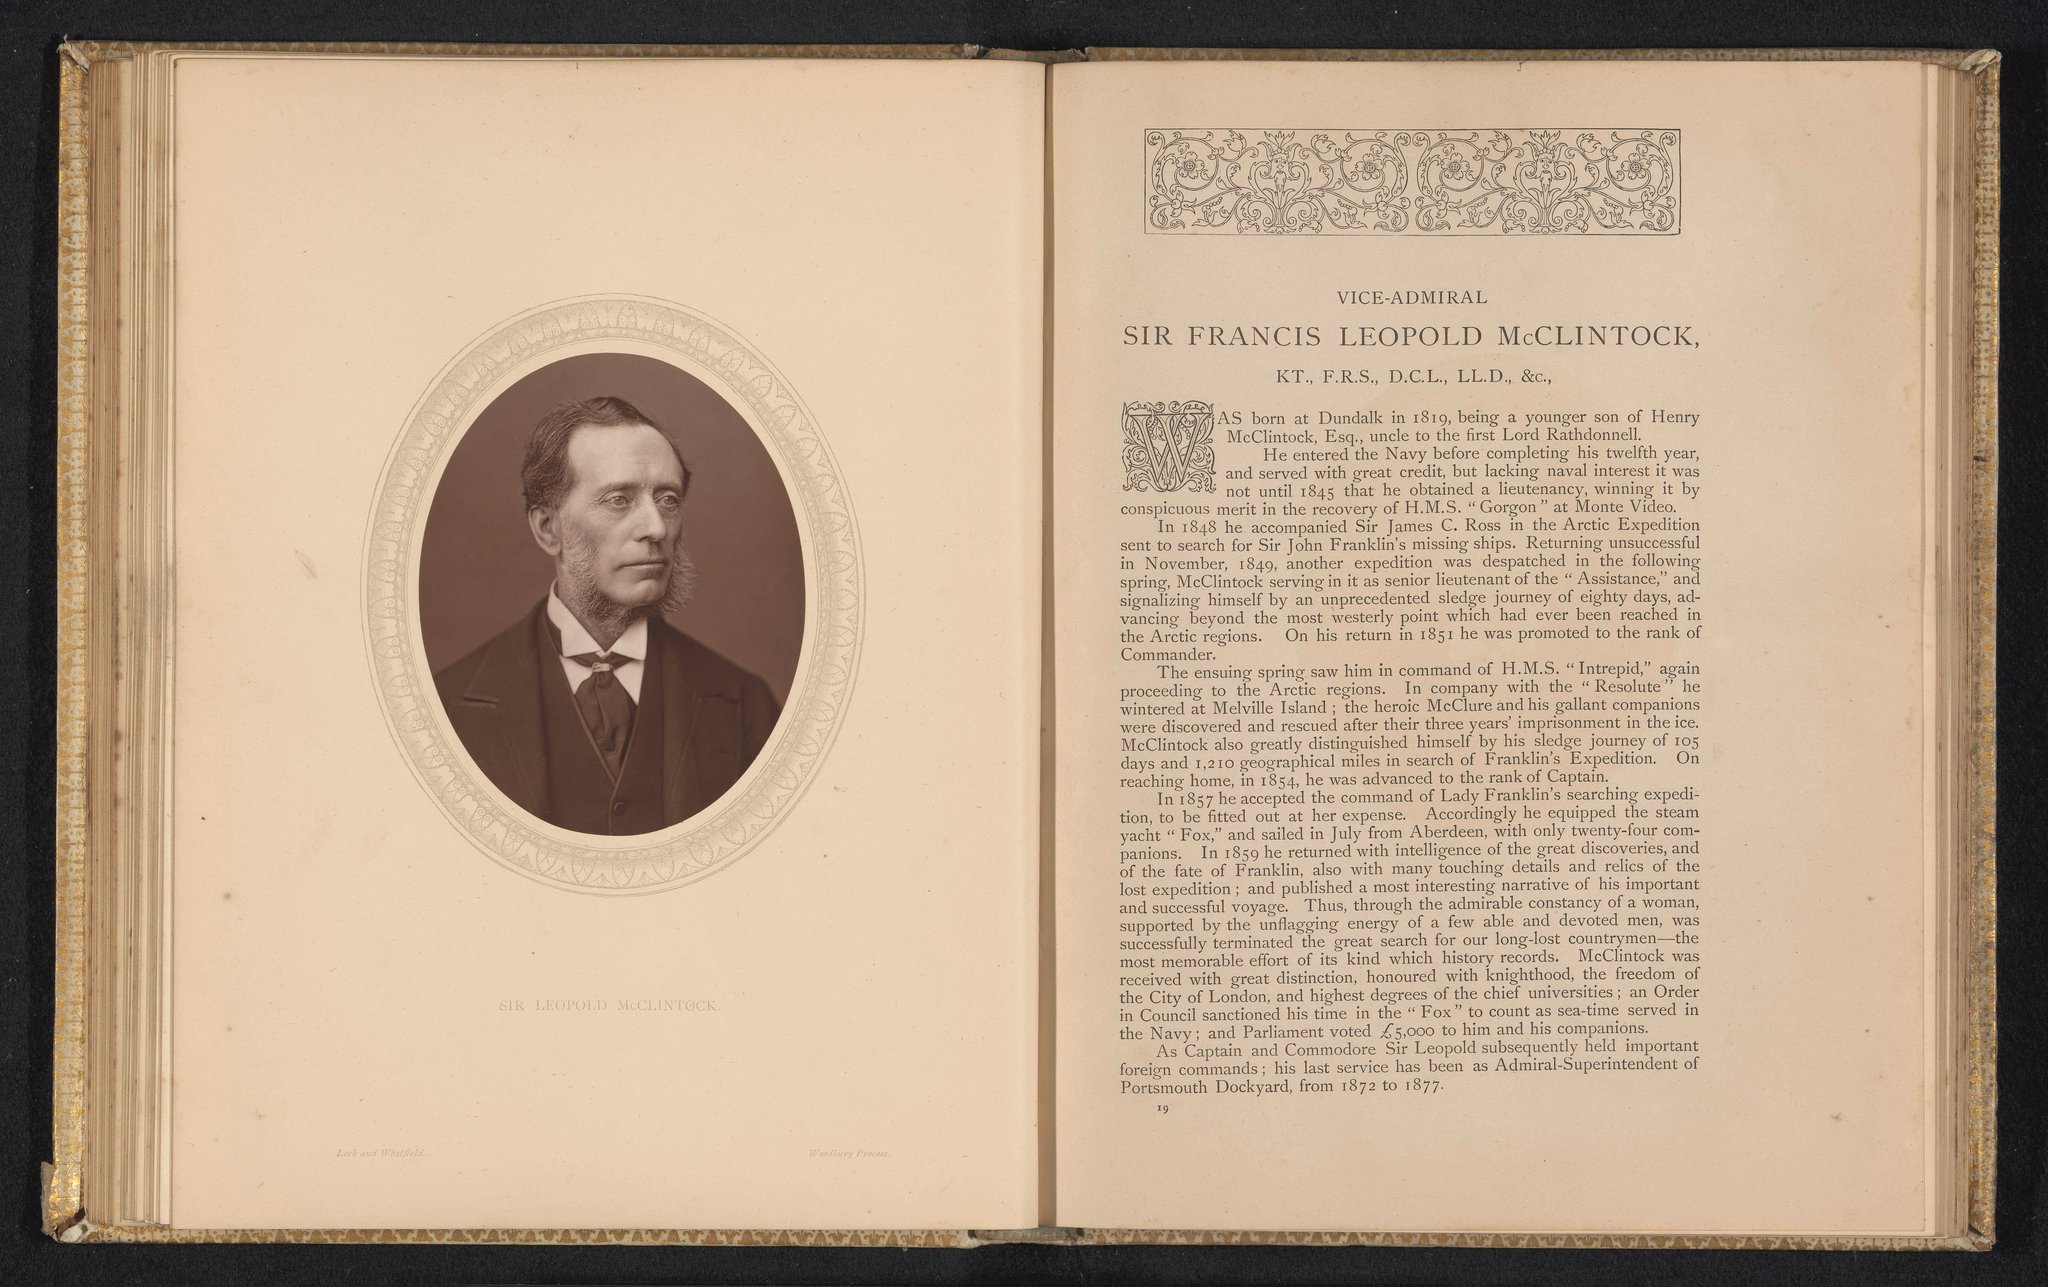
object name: photomechanical print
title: Sir Leopold McClintock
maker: Anonymous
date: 1873-1878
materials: paper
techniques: woodburytype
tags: london, historical persons (portraits and scenes from the life) (+ (full) bust portrait), explorer